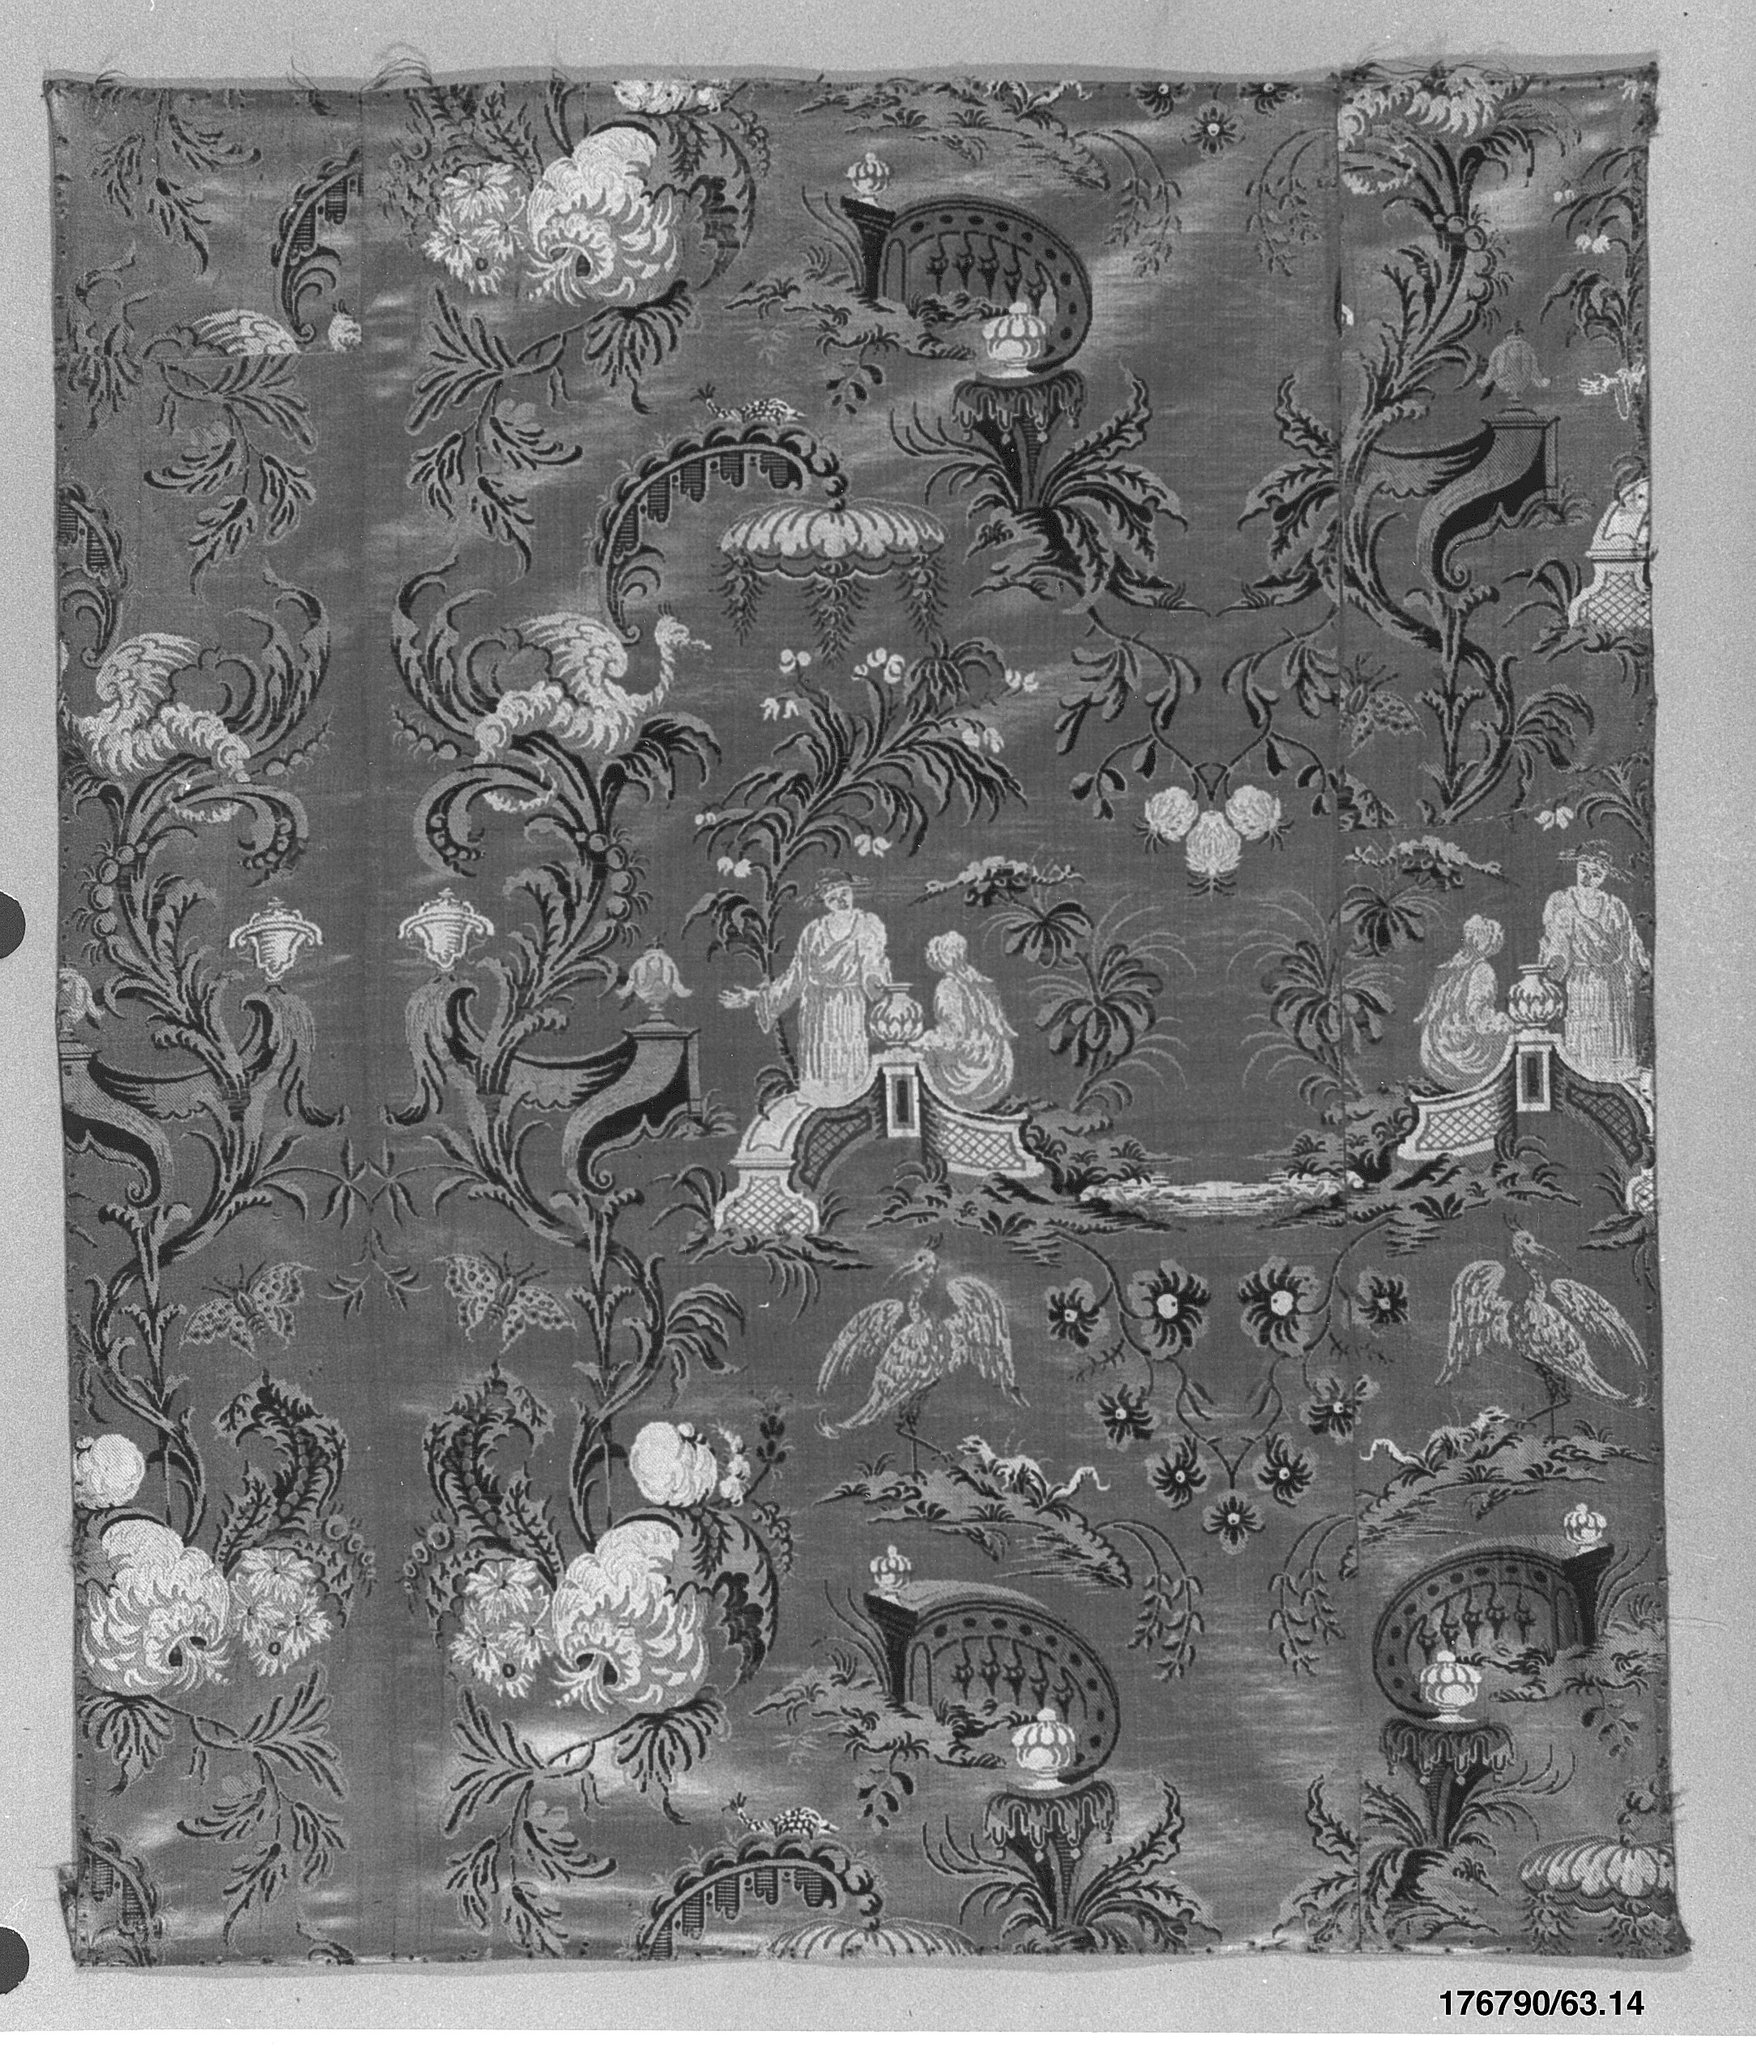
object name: panel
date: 1740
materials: silk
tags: human figures,birds,flowers